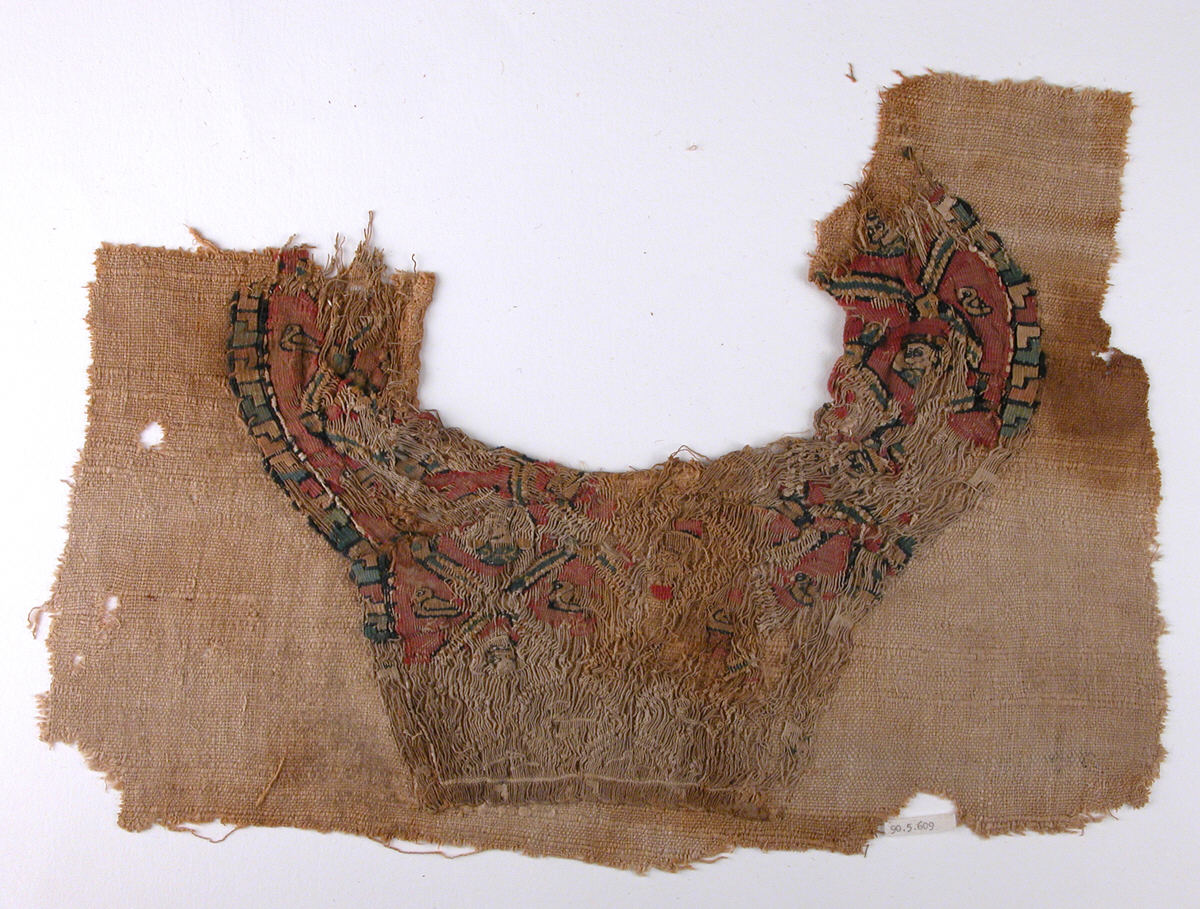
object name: textile fragment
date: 501-700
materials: linen, wool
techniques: weave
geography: egypt